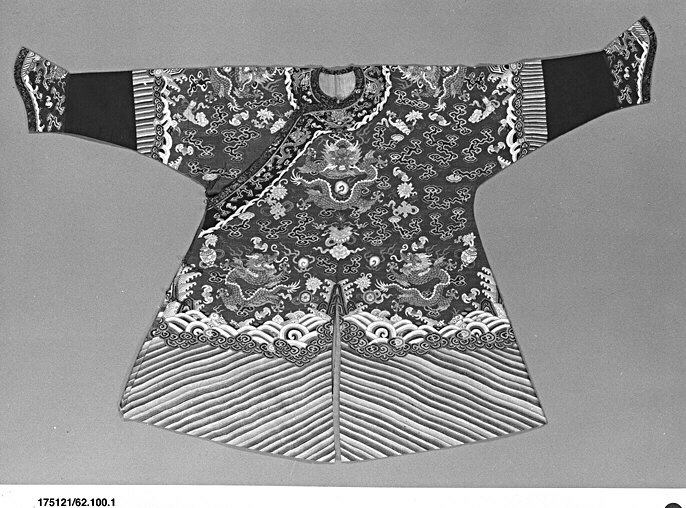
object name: robe, boy's imperial court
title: Boy's Imperial Court Robe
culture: chinese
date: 1801-1900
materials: metal thread, silk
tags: dragons